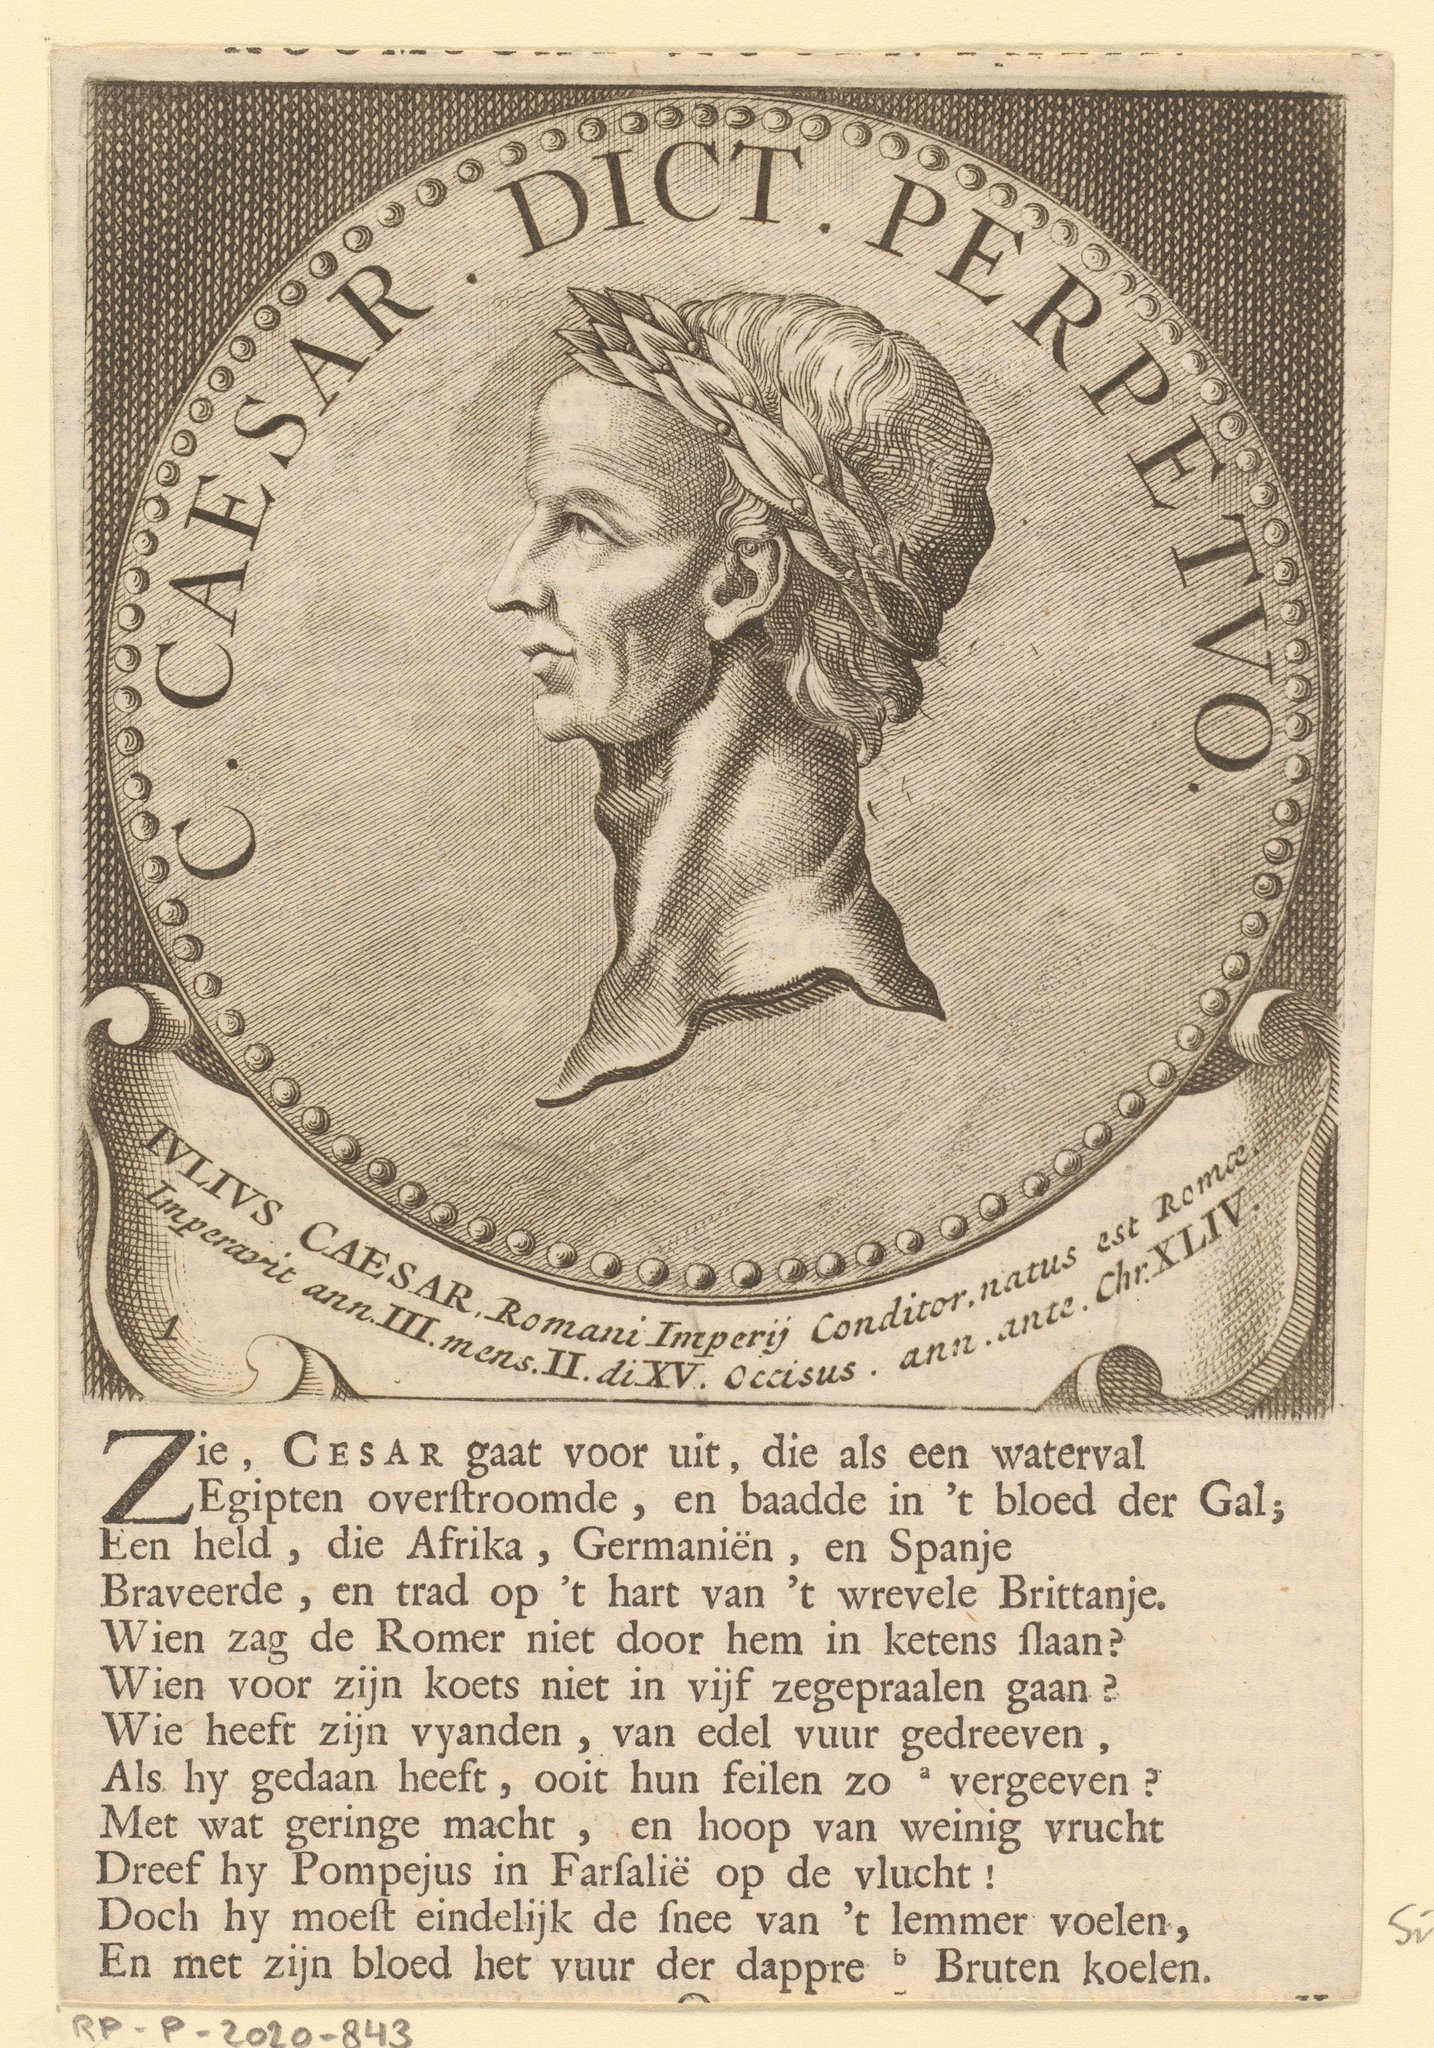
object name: book illustration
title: Portret van Julius Caesar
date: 1697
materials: paper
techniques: engraving, etching, letterpress printing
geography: utrecht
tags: rome, portrait of caesar, historical persons, emperor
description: Prent uit: Bogaert, Abraham. De Roomsche monarchy, vertoont in de muntbeelden der westersche en oostersche keizeren (...). Utrecht: François Halma en Willem van de Water, 1697, p. 109. Eerste staat verschenen in een grotere prent met twaalf portretten, gedateerd 1695.